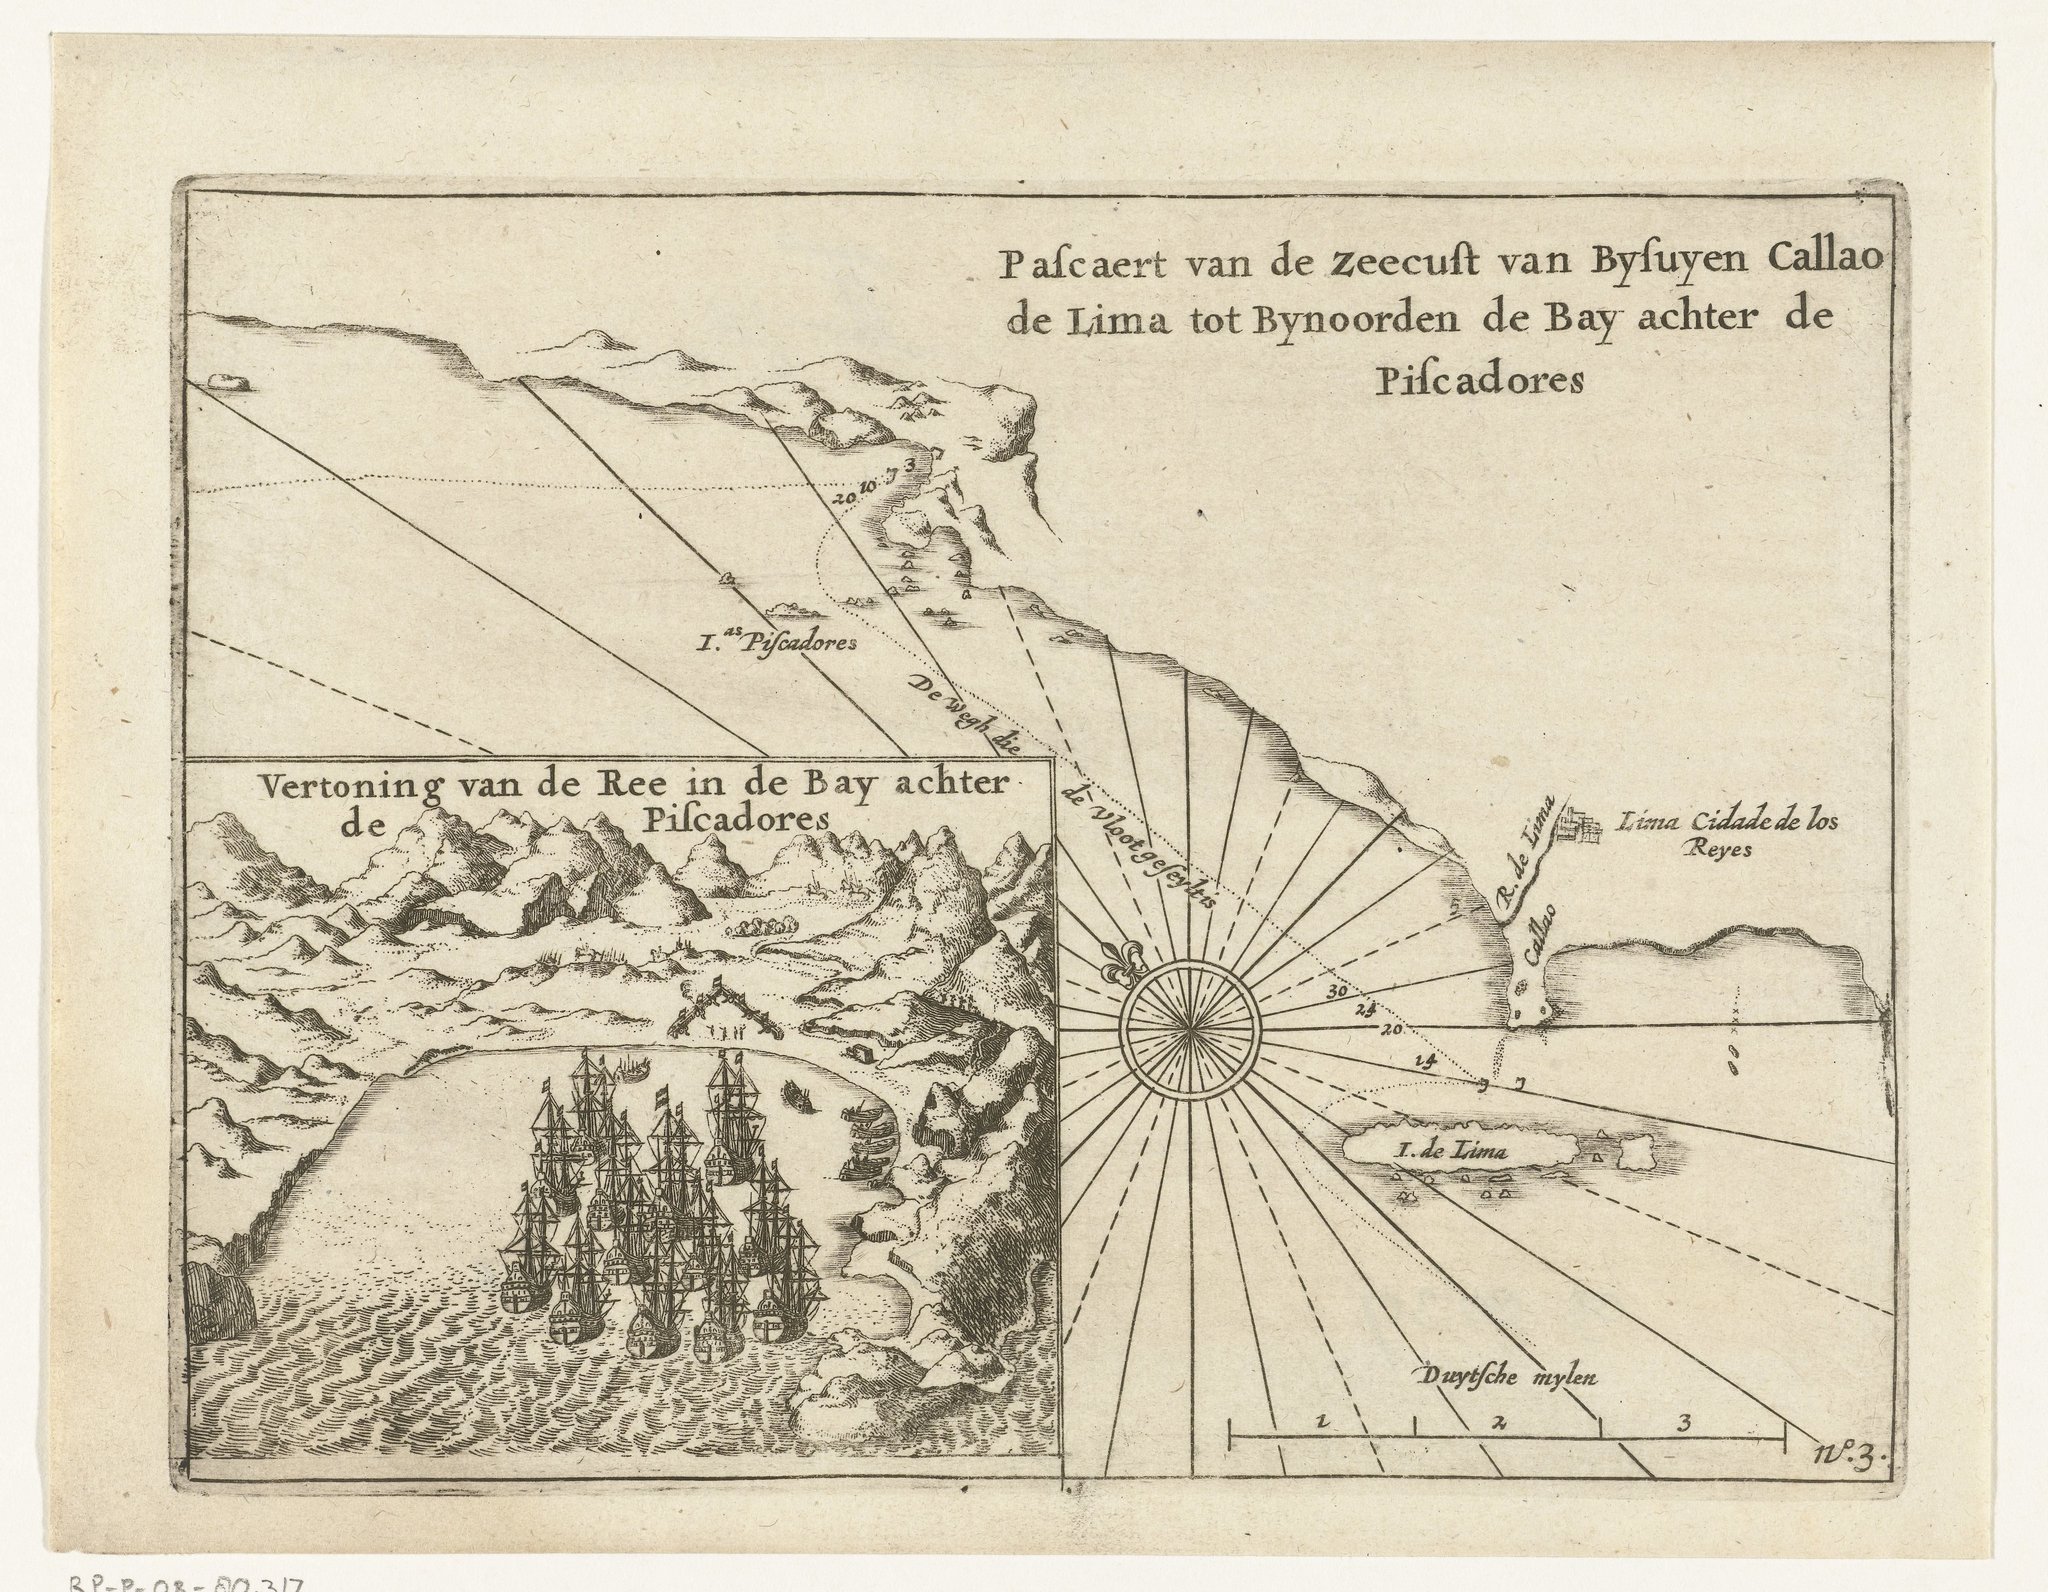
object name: print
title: Pascaert van de Zeecust van Bysuyen Callao de Lima tot Bynoorden de Bay achter de Piscadores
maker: Anonymous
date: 1644-1646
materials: paper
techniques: engraving, etching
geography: northern netherlands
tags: jacques l' heremite (ii), maps of separate countries or regions, landscapes in tropical and sub-tropical regions, exploration, expedition, voyage of discovery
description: Oorspronkelijke illustraties eerst gebruikt in: Johan van Walbeeck, Iovrnael vande Nassausche vloot, ofte Beschryvingh vande voyagie om den gantschen aerdt-cloot (...) onder't beleydt vanden admirael Iaques l'Heremite, H. Gerritsz en J.P. Wachter, Amsterdam 1626. Kopieën naar deze platen gebruikt in: Journael van de Nassausche Vloot, ofte Beschrijvingh van de Voyagie om den gantschen Aerd-Kloot, Gedaen met elf Schepen: Onder 't Beleydt van den Admirael Jaques l'Heremite, Ende Vice-Admirael Gheen Huygen Schapenham, In de Jaren 1623. 1624. 1625. en 1626. Opgenomen in: I. Commelin, Begin ende voortgangh, van de Vereenighde Nederlantsche Geoctroyeerde Oost-Indische Compagnie, J. Janssonius, Amsterdam 1646. Genummerd: No. 3.